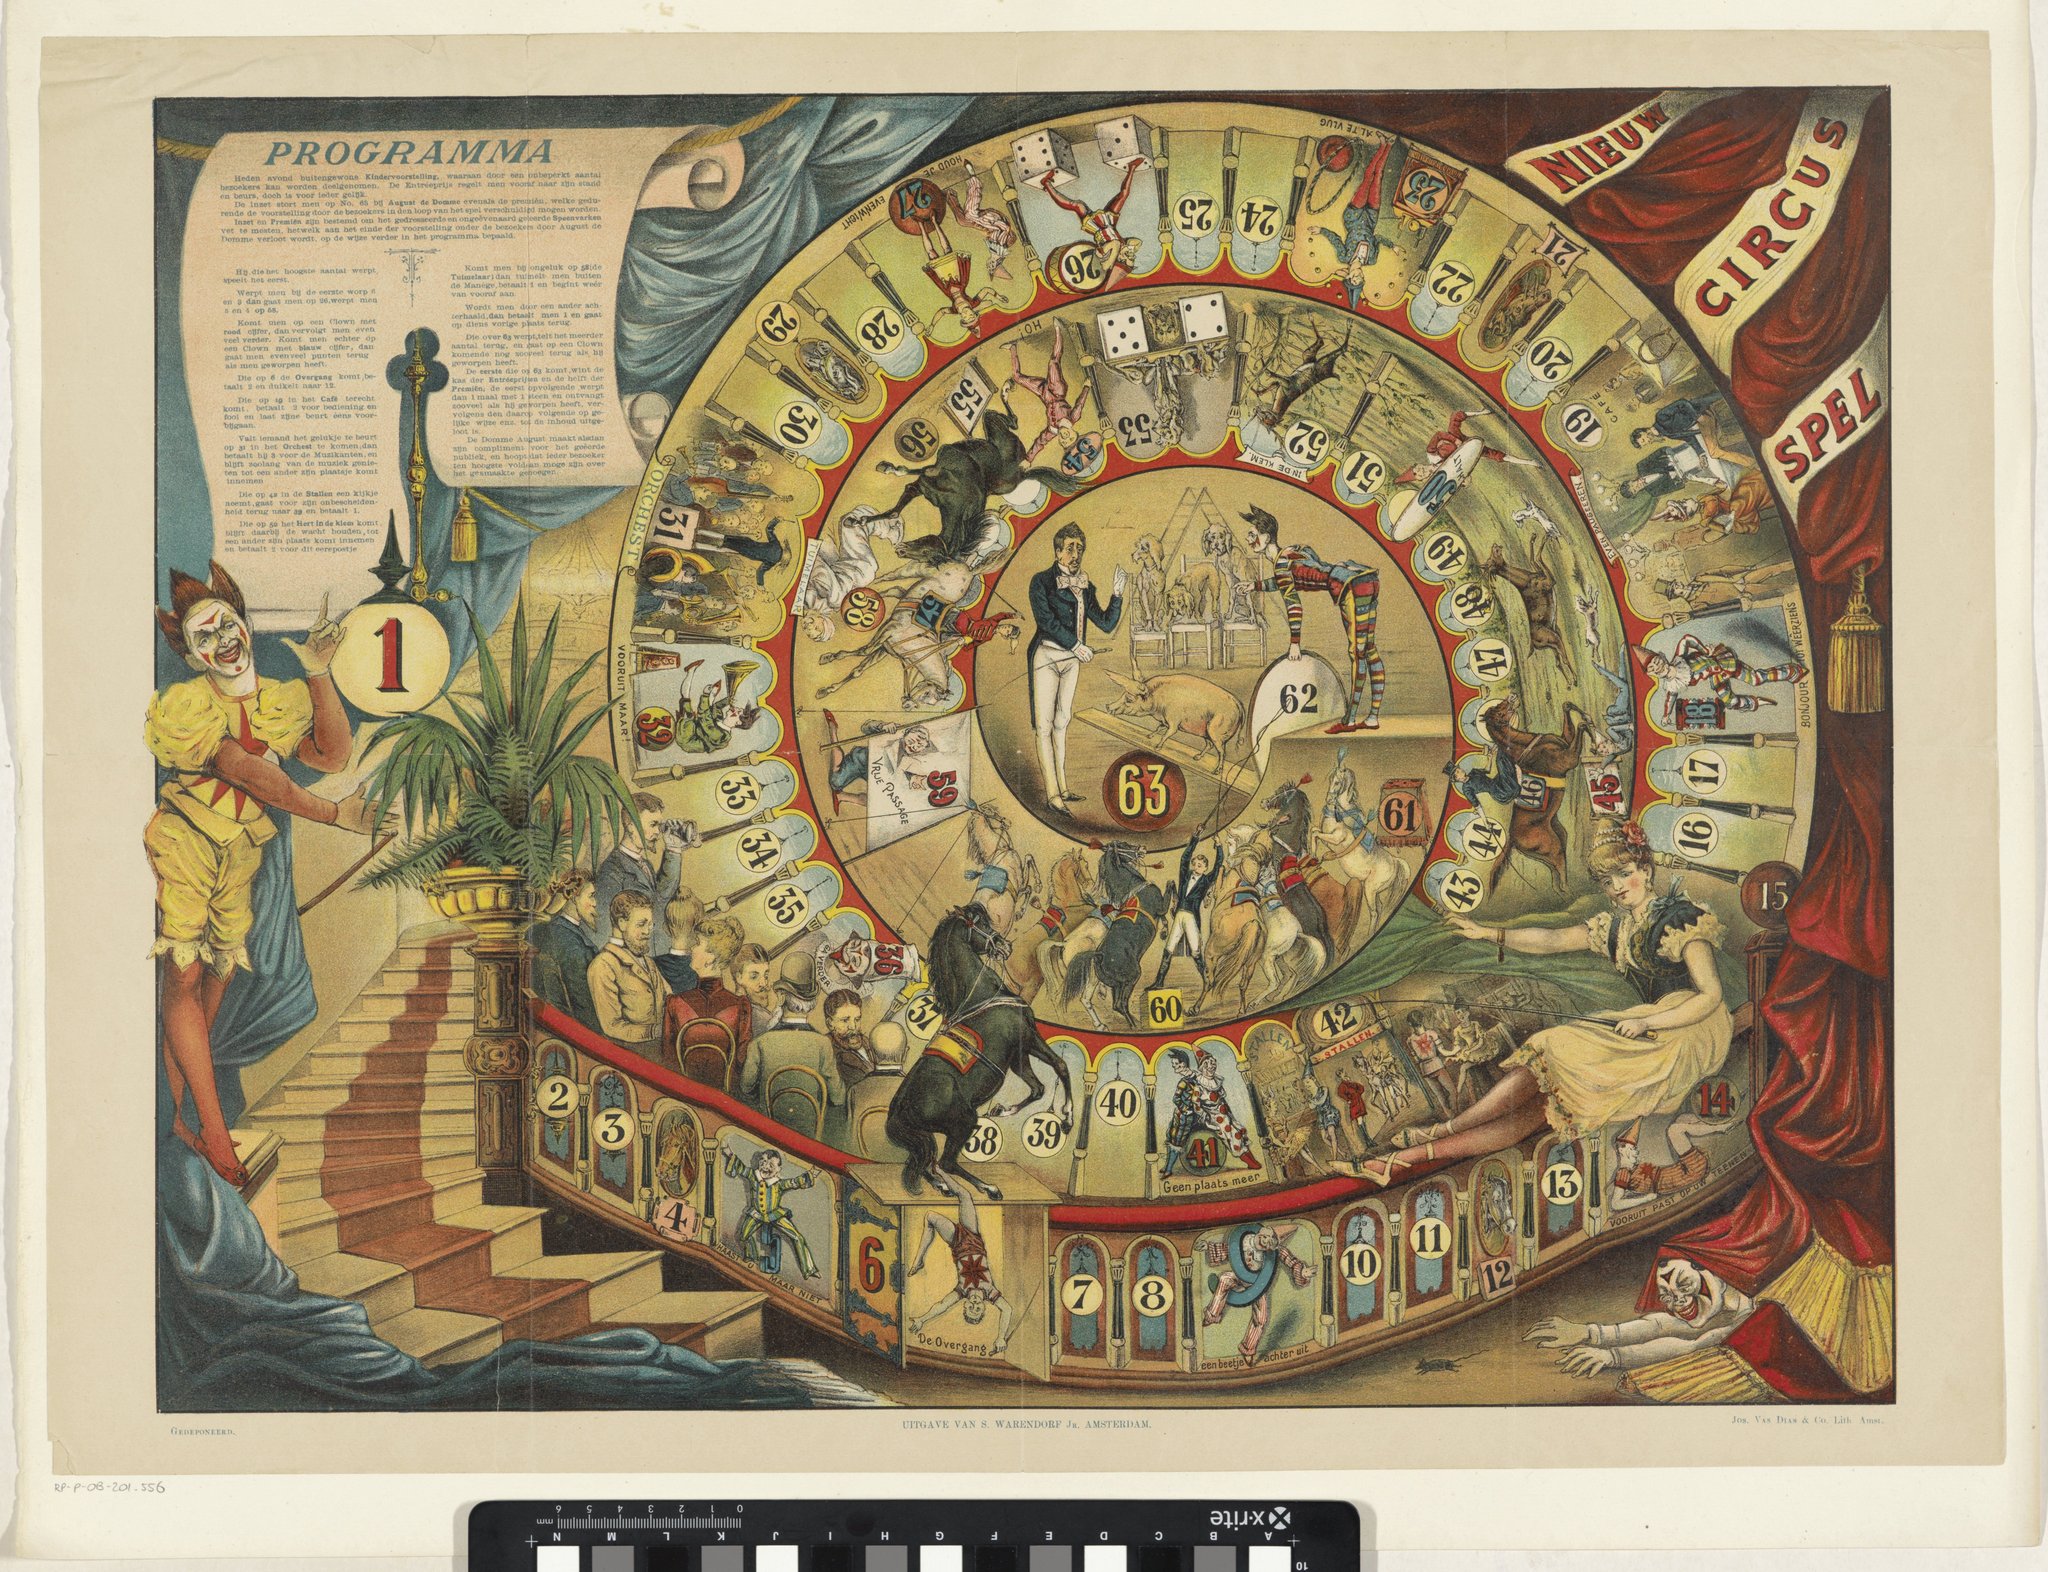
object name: gameboard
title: Nieuw / circus / spel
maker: s. warendorf (ii)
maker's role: publisher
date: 1887-1891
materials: paper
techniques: lithograph, letterpress printing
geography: amsterdam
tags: board-games of chance, circus, clown, board-games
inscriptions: collector's mark: Lugt 2760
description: Bordspel met spiraal met vakjes genummerd van 1 tot en met 63. Ganzenbordachtig spel met clowns in plaats van ganzen. Links een grote clown. Linksboven de spelregels.